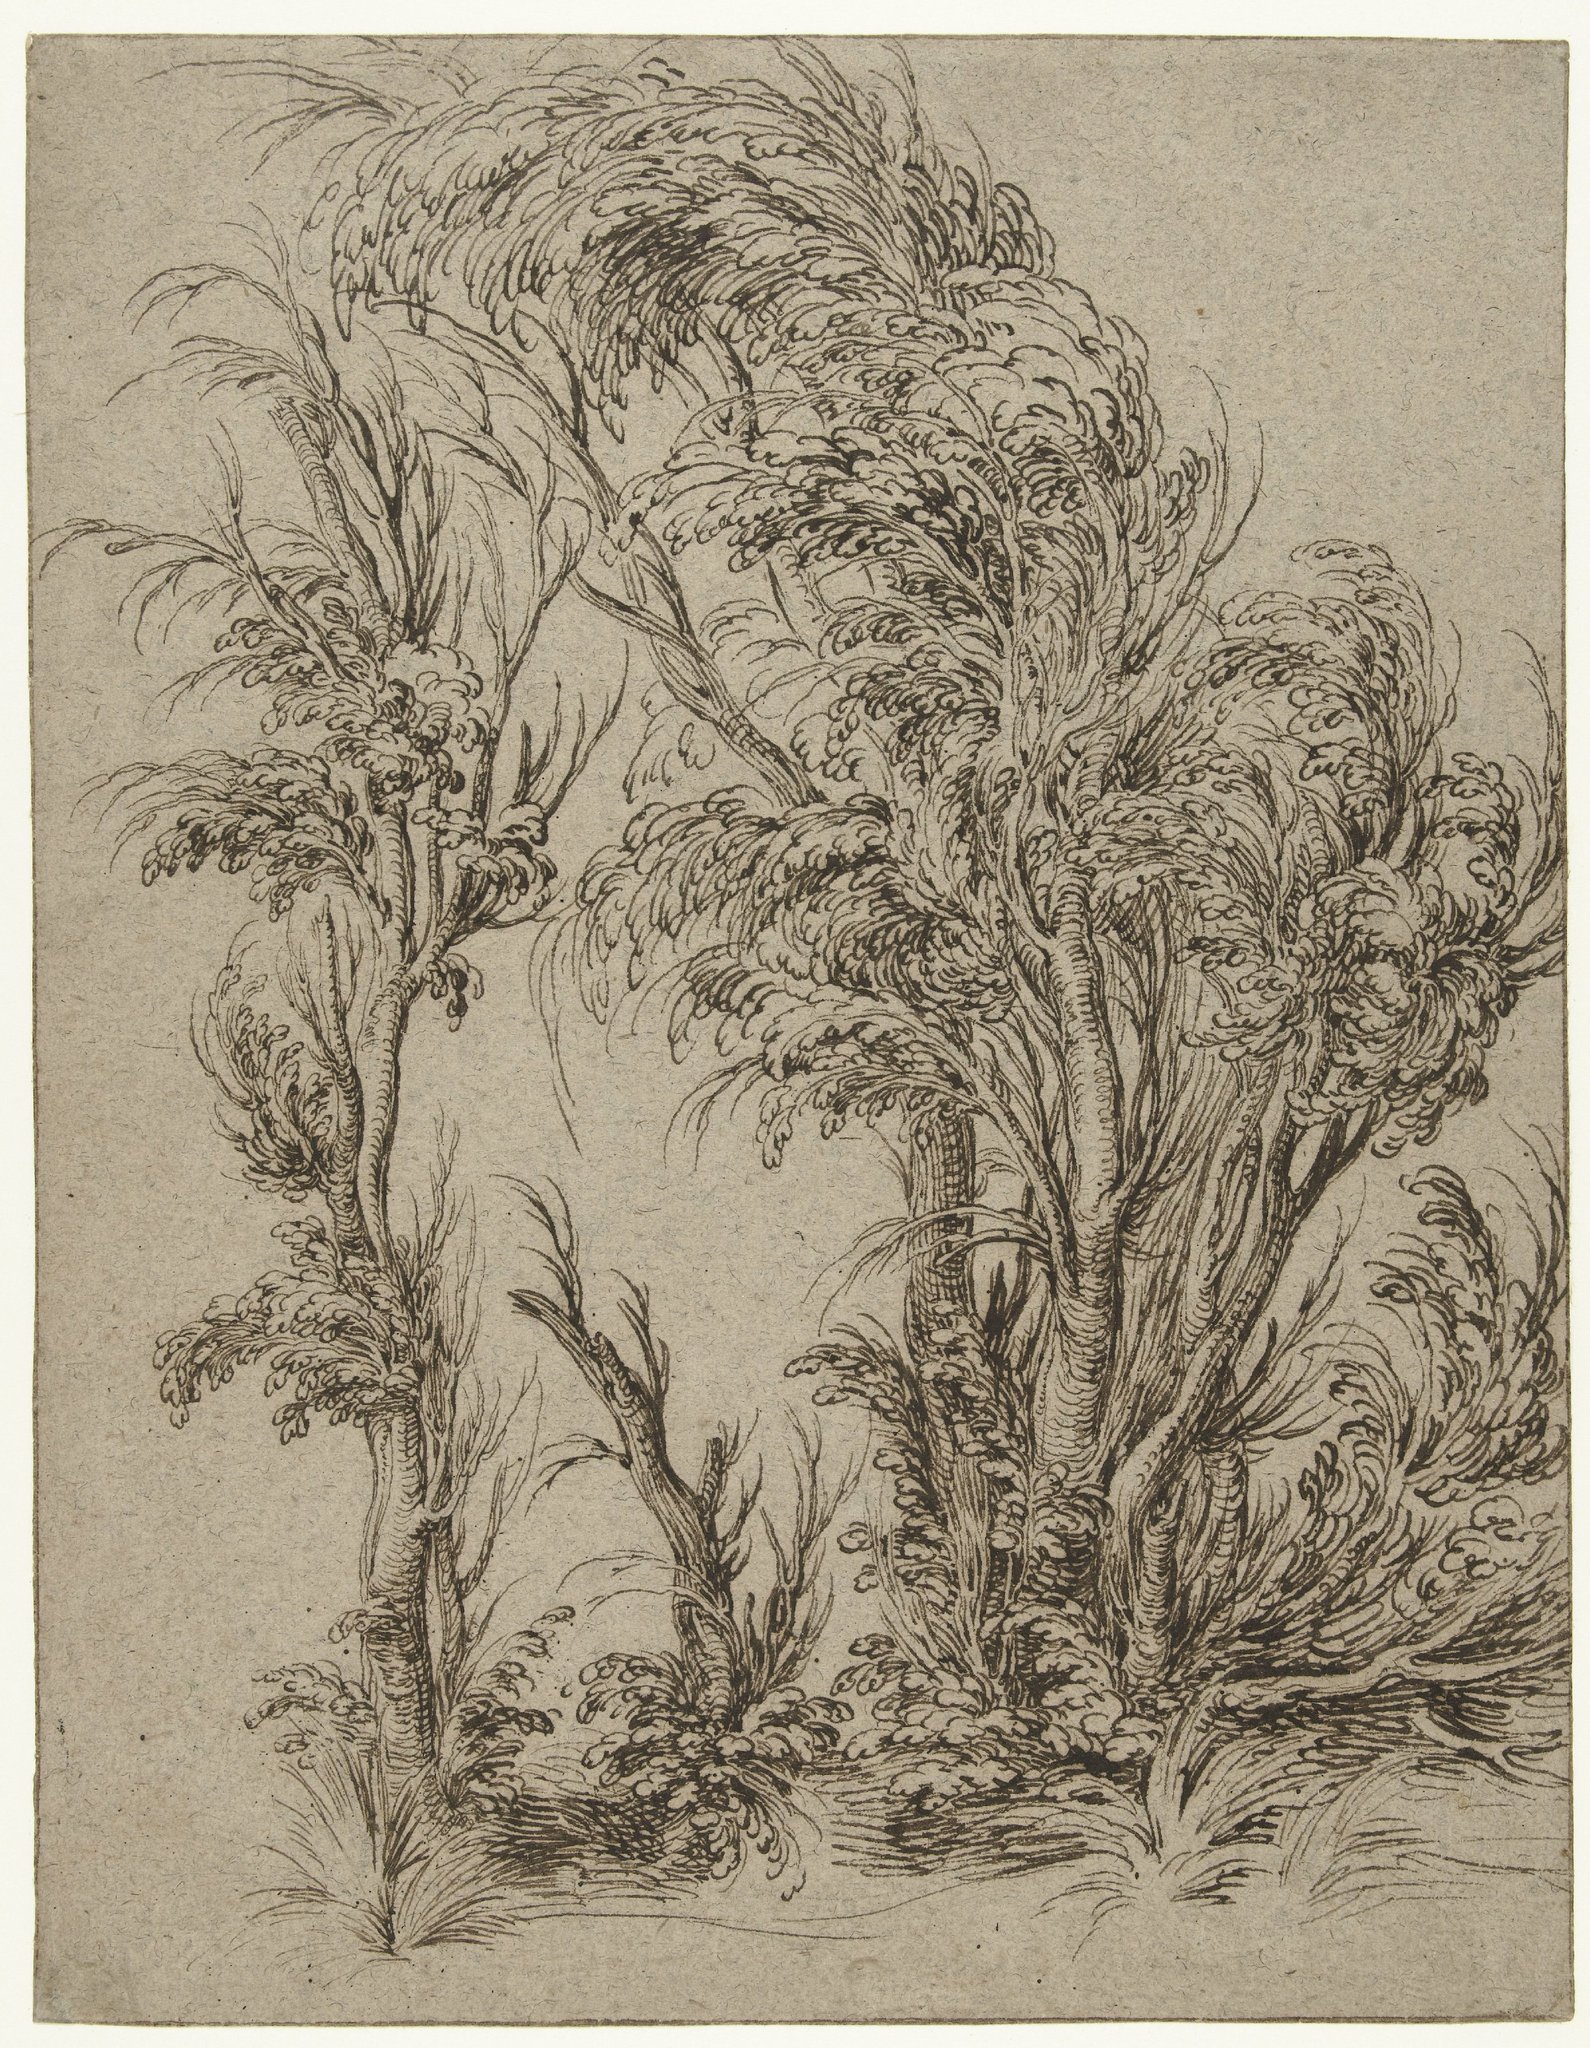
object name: drawing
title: Trees in the wind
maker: jacques de gheyn (ii)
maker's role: painter, print maker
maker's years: 1565-1629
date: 1598-1608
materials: paper, chalk, ink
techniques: pen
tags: shrubs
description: A breeze seems to be blowing in this drawing. With fluid and rhythmic lines Jacques de Gheyn created the impression of trees swaying in the wind. De Gheyn was not interested so much in making a naturalistic depiction, as giving free rein to his imagination.